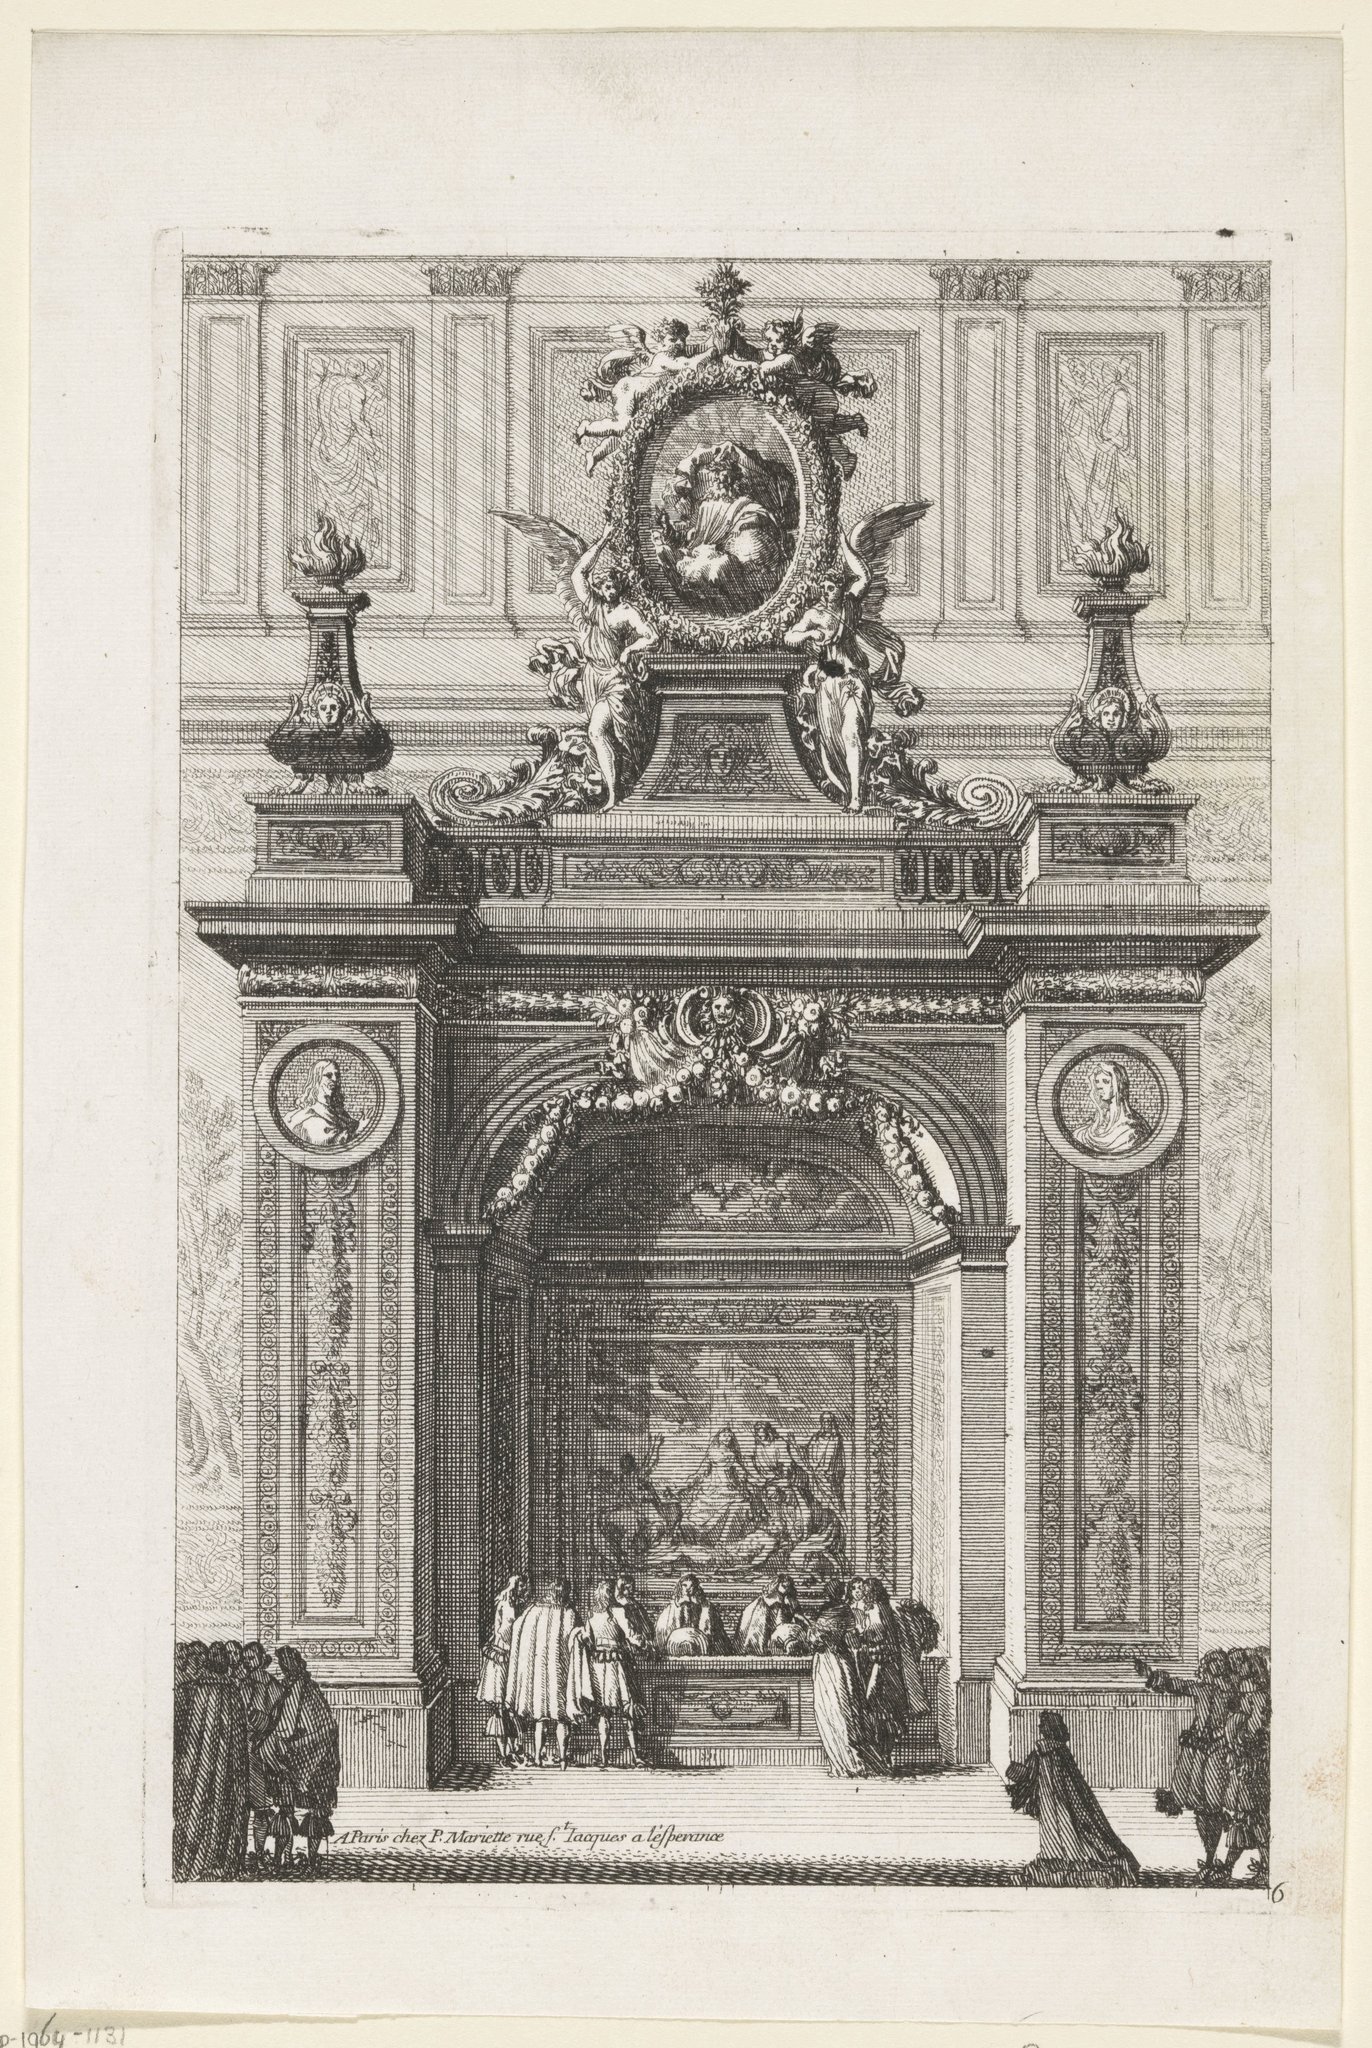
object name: print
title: Nouuelles Inuentions pour faire les bancs des choeur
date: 1657-1665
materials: paper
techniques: etching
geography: france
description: Aan weerskanten staan pijlers bekroond met vlammende balusters. Uit tweede editie.